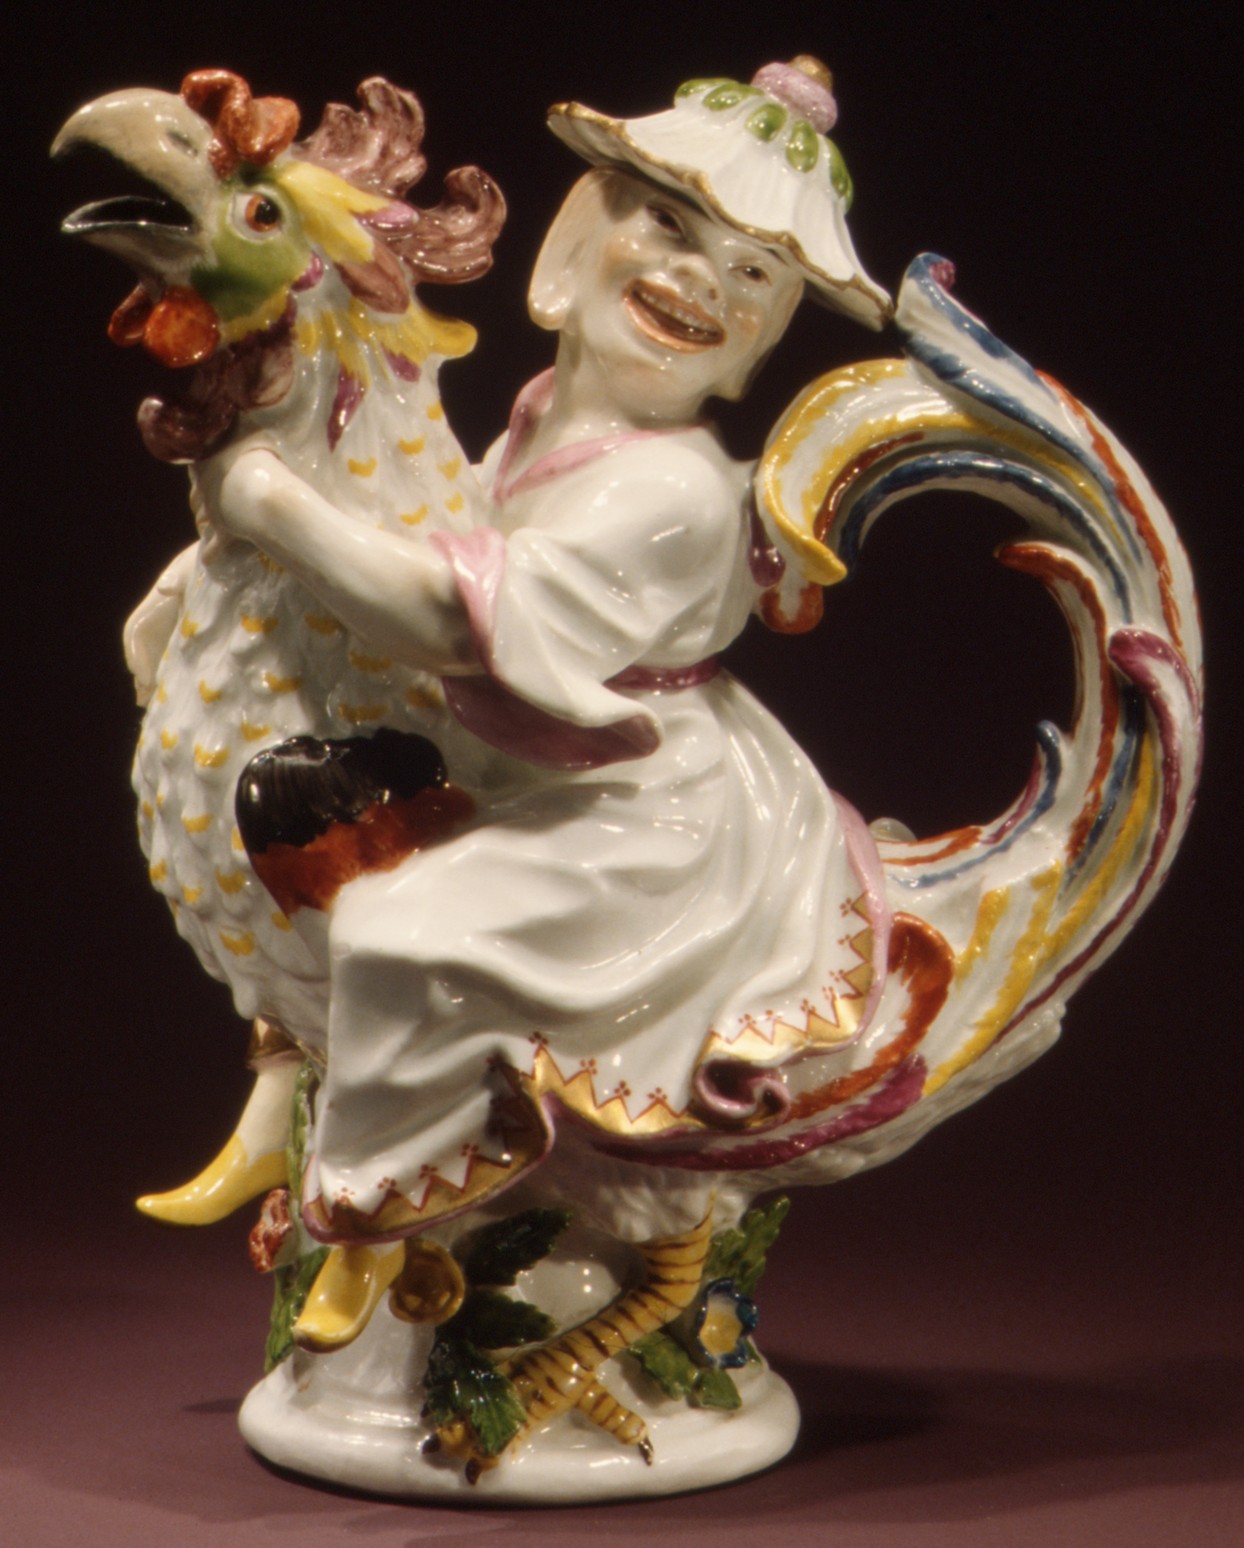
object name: cruet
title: Oil or vinegar cruet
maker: meissen manufactory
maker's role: manufactory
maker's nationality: german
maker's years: 1710-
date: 1737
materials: hard paste porcelain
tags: women,roosters